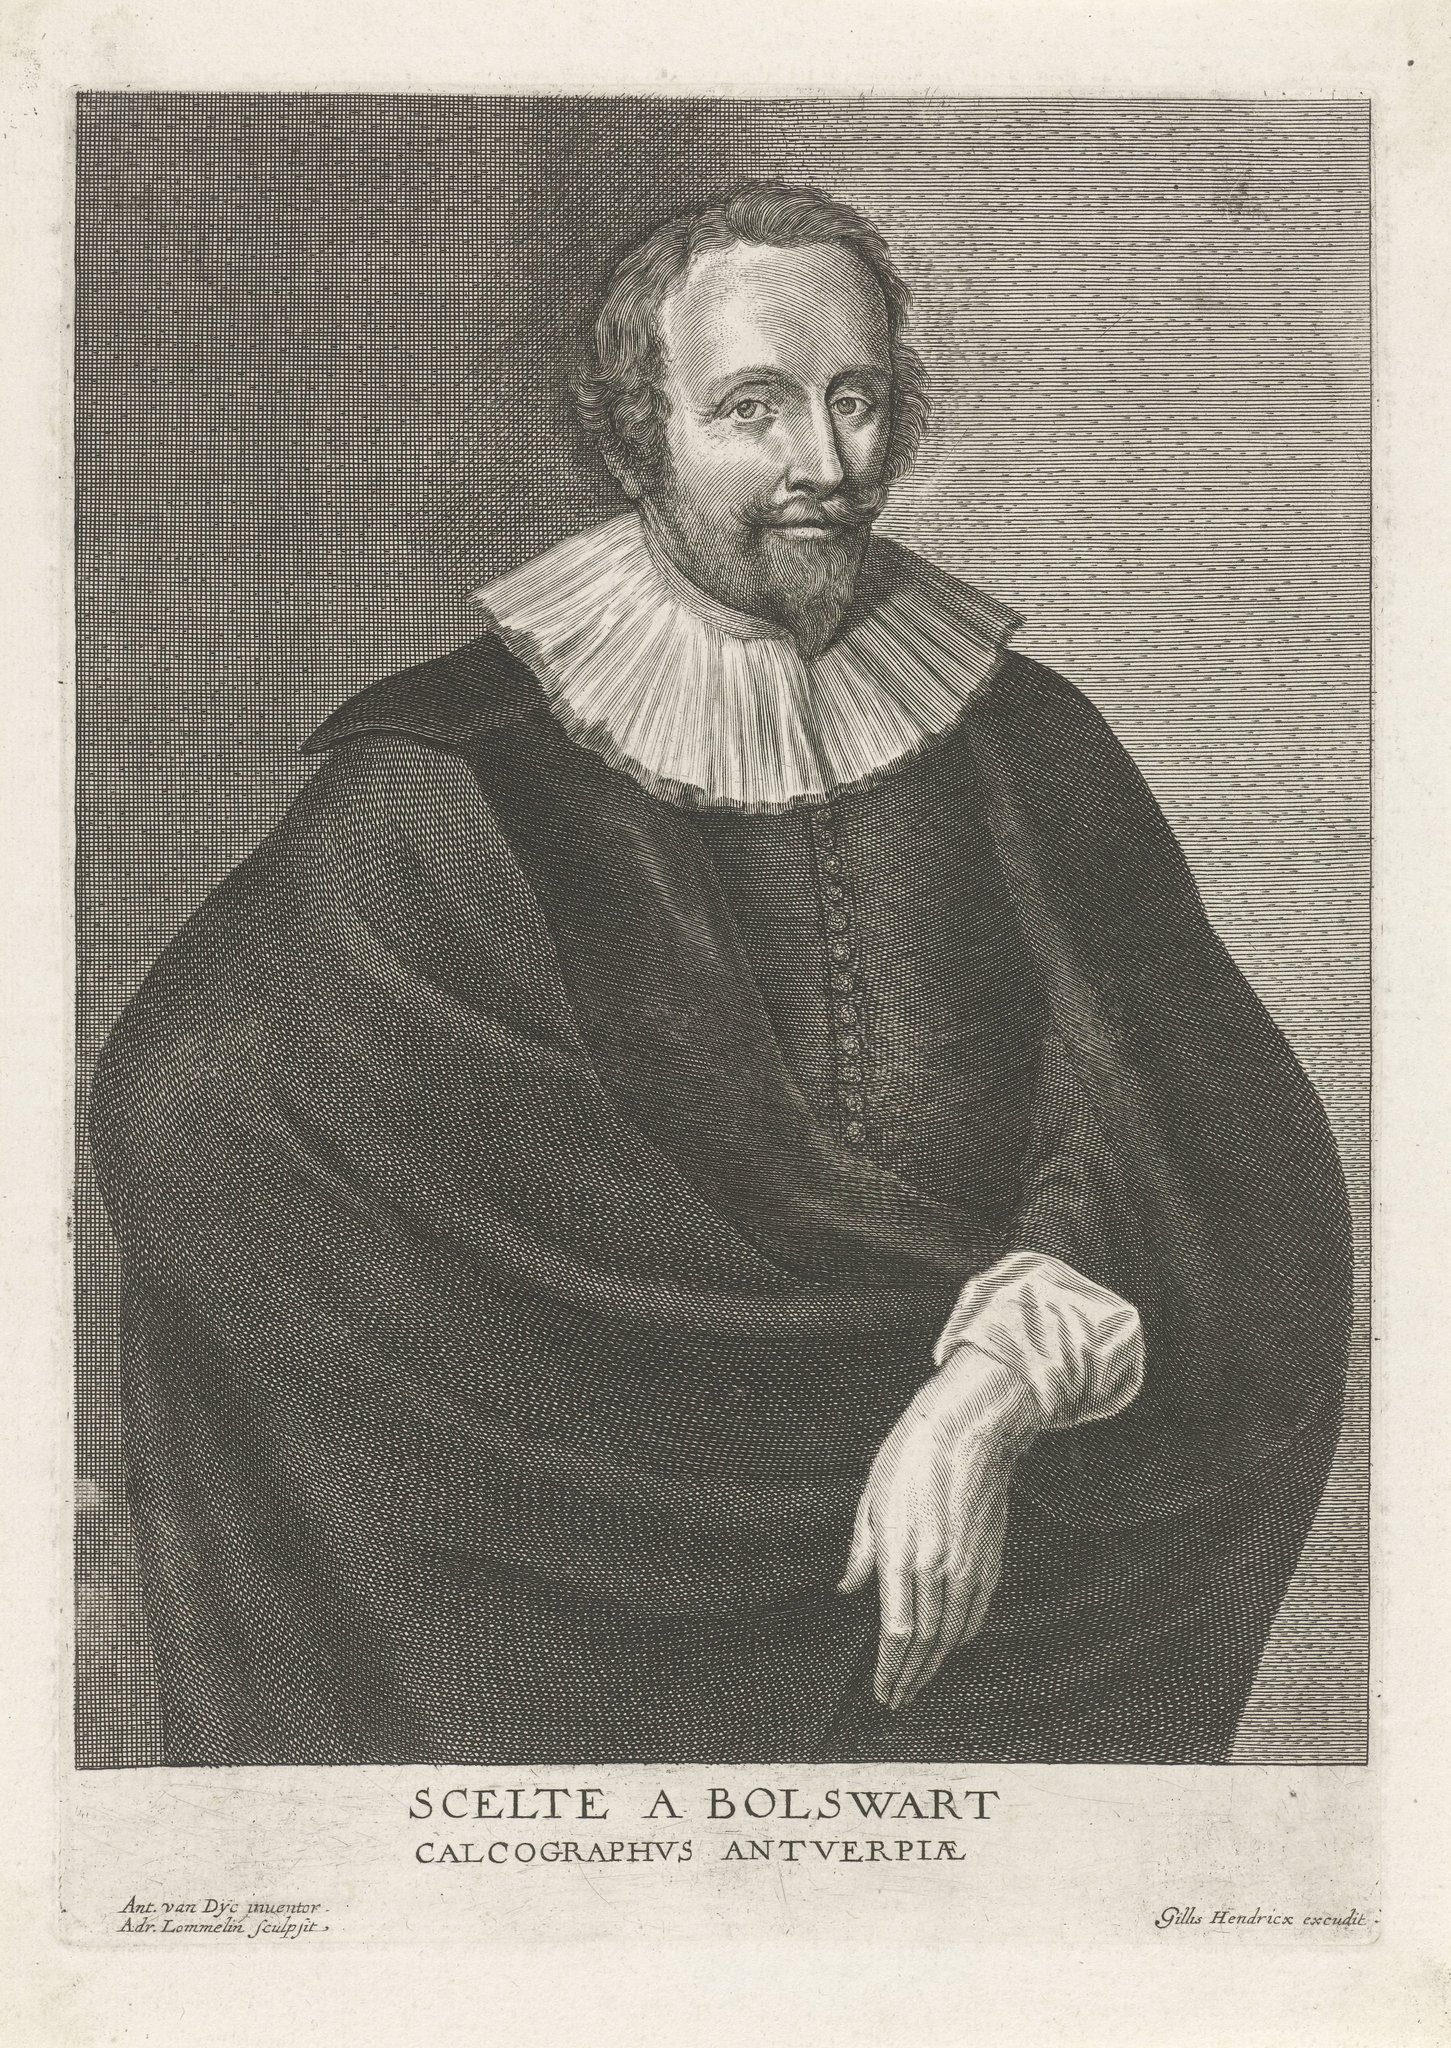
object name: print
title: Portret van Schelte Adamsz. Bolswert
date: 1630-1677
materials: paper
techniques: engraving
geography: antwerp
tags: antwerp, schelte adamsz. bolswert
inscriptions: collector's mark: Lugt 240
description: Portret van Schelte Adamsz. Bolswert, prentmaker te Antwerpen.